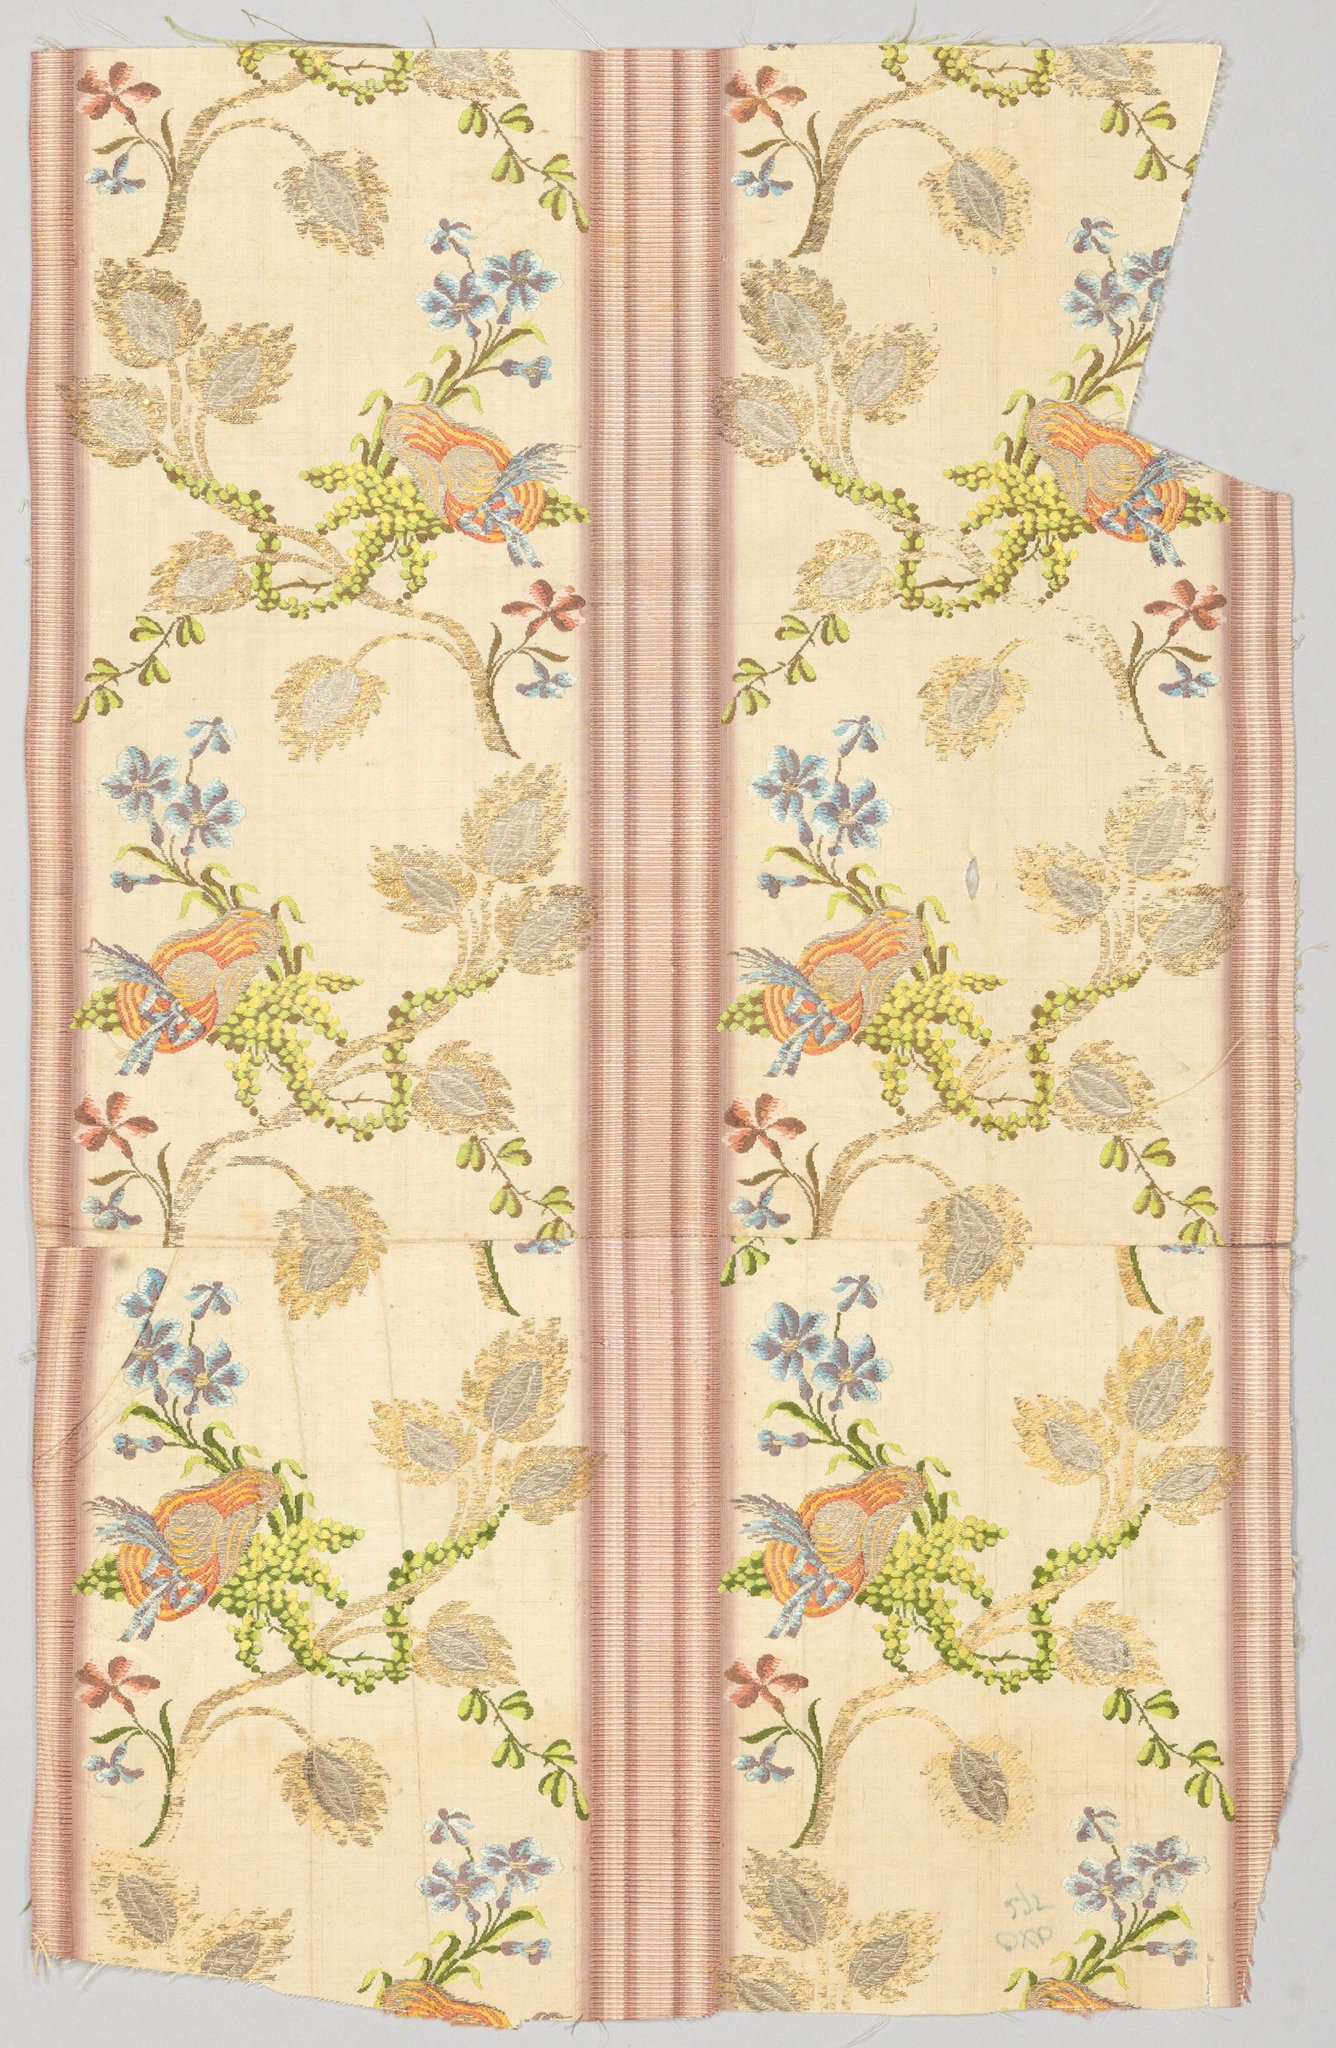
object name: fragment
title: Baan gebrocheerde Gros de Tours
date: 1765-1775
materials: gold thread, silk, thread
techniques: brocade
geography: france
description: Baan gebrocheerde Gros de Tours, met plaatselijk aangebrachte extra inslag van goud- en zilverdraad. Dessin: verticale banden met strepen in verscyhillende tinten roze waartussen verticale golvende ranken met bladeren in zilver- en gouddraad en strengen, opgebouwd uit erwtvormen waarop een zonnehoed met strik en veer in verschillende tinten en bloemen in groen, oranje, geel, blauw, aubergine en zilverdraad (brochering) op een cremekleurig fond. Aan achterzijde geschreven: OX 0275. achterzijde op de stof gestempeld: 47583C. Papiertje met de